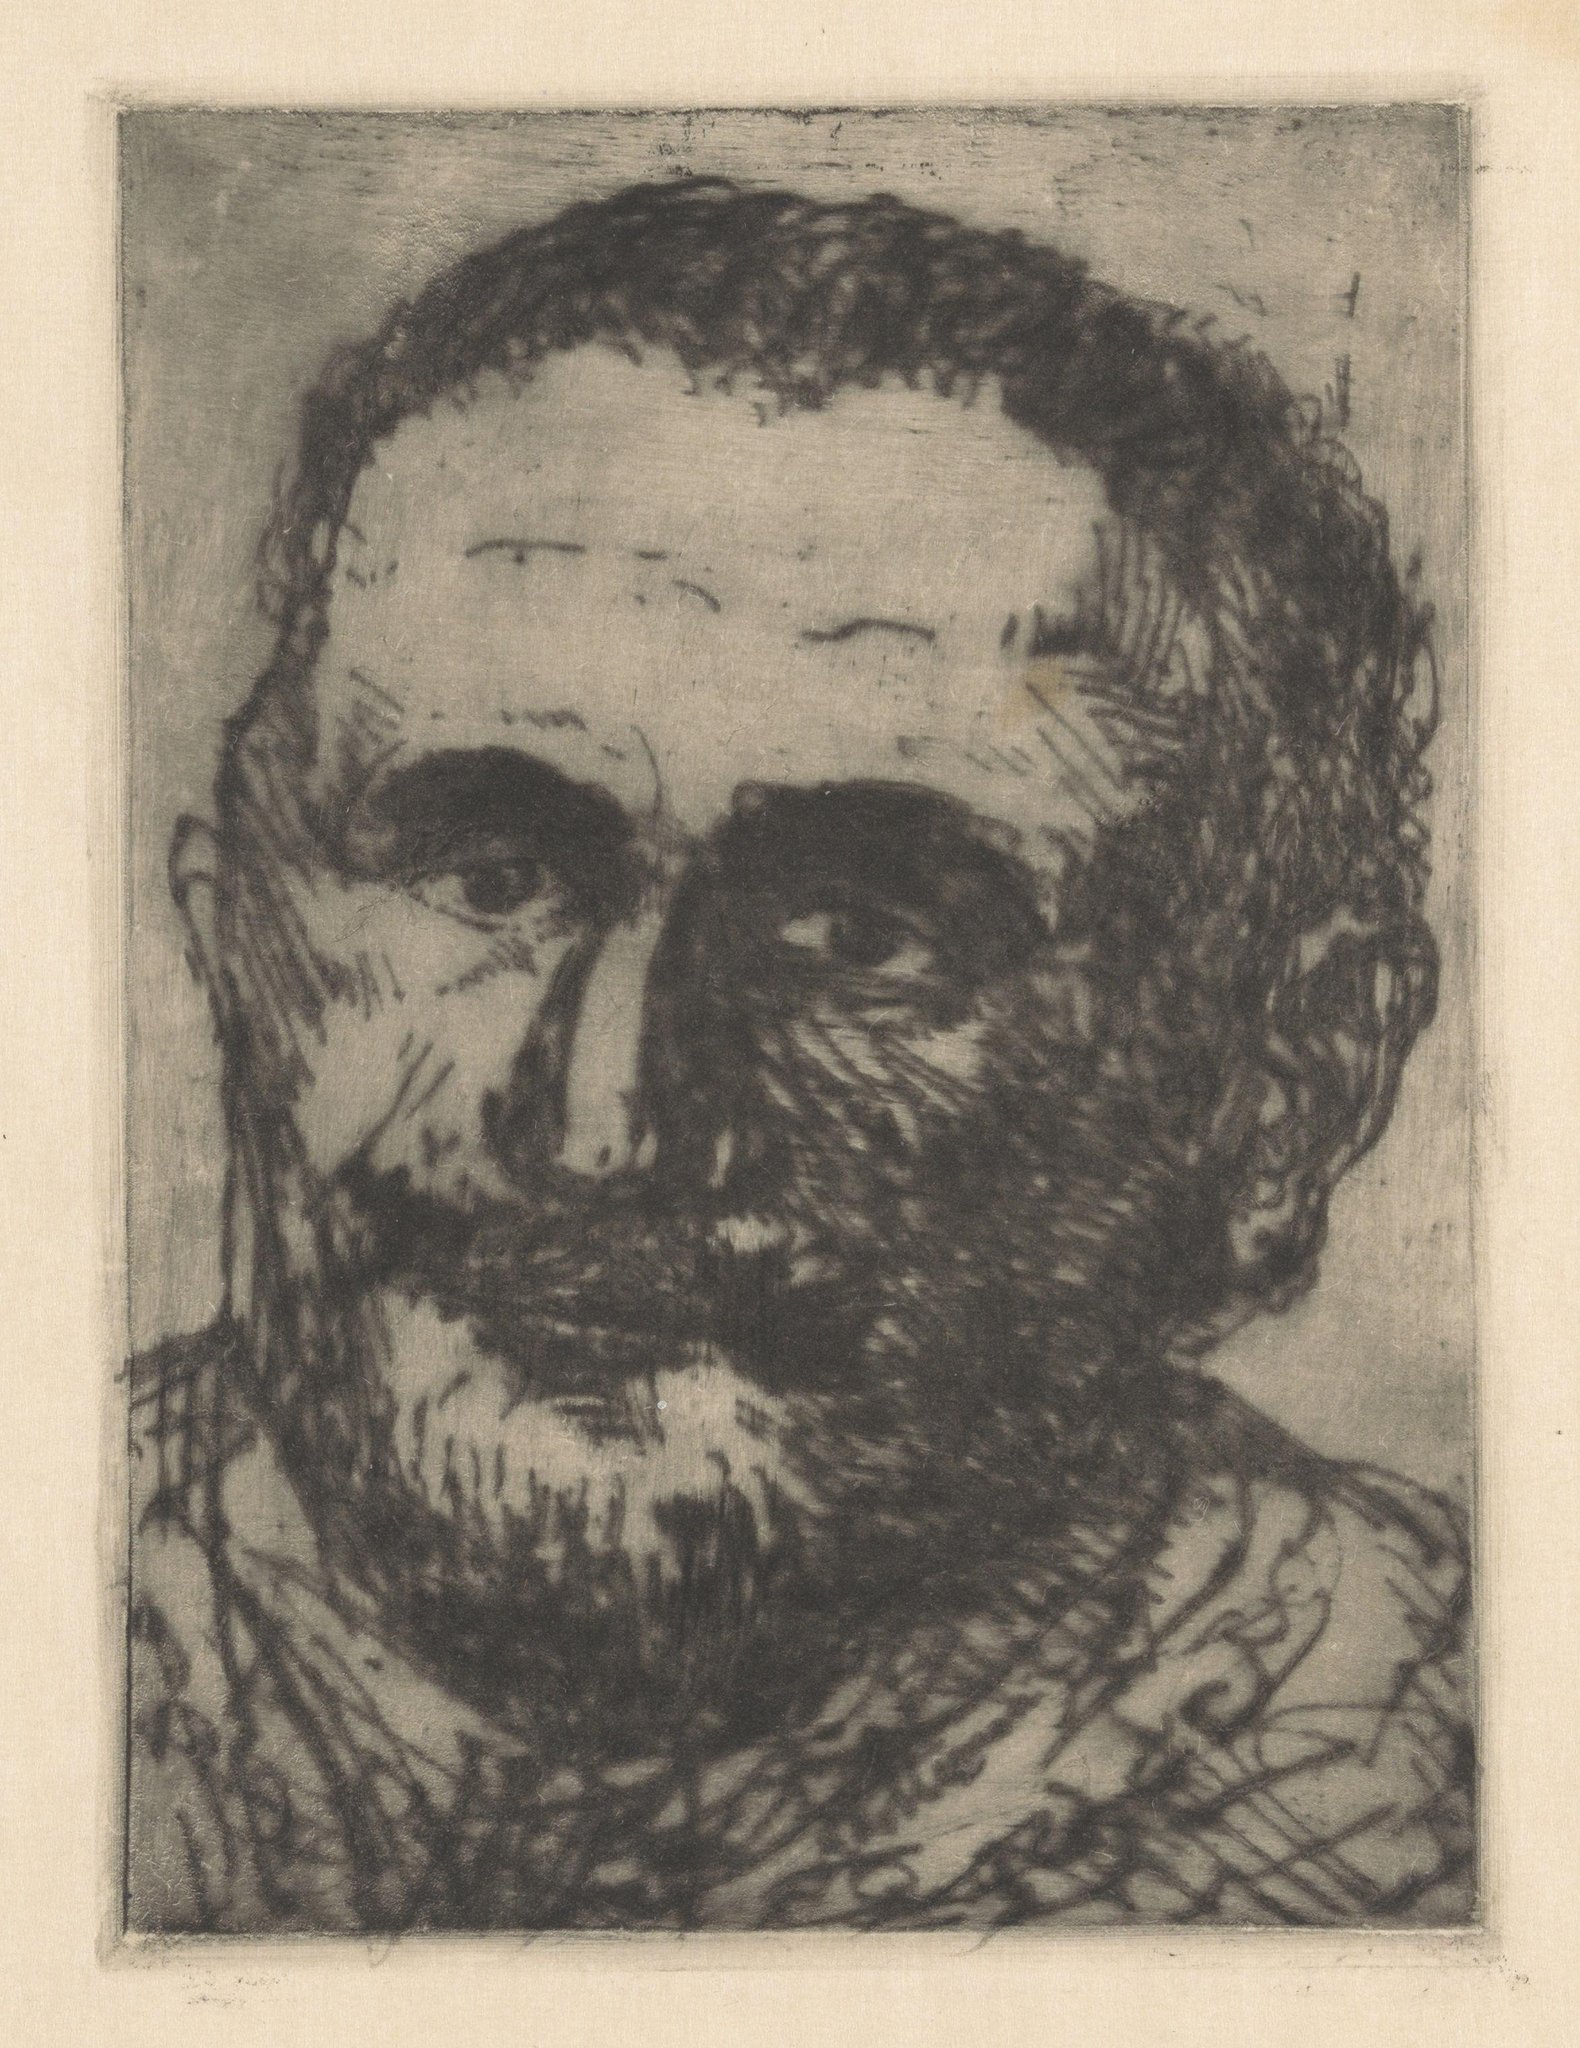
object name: print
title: Man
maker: marius holleman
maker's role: draughtsman, print maker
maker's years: 1878-1926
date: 1917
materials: paper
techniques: etching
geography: groningen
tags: adult man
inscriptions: collector's mark: Lugt 2228